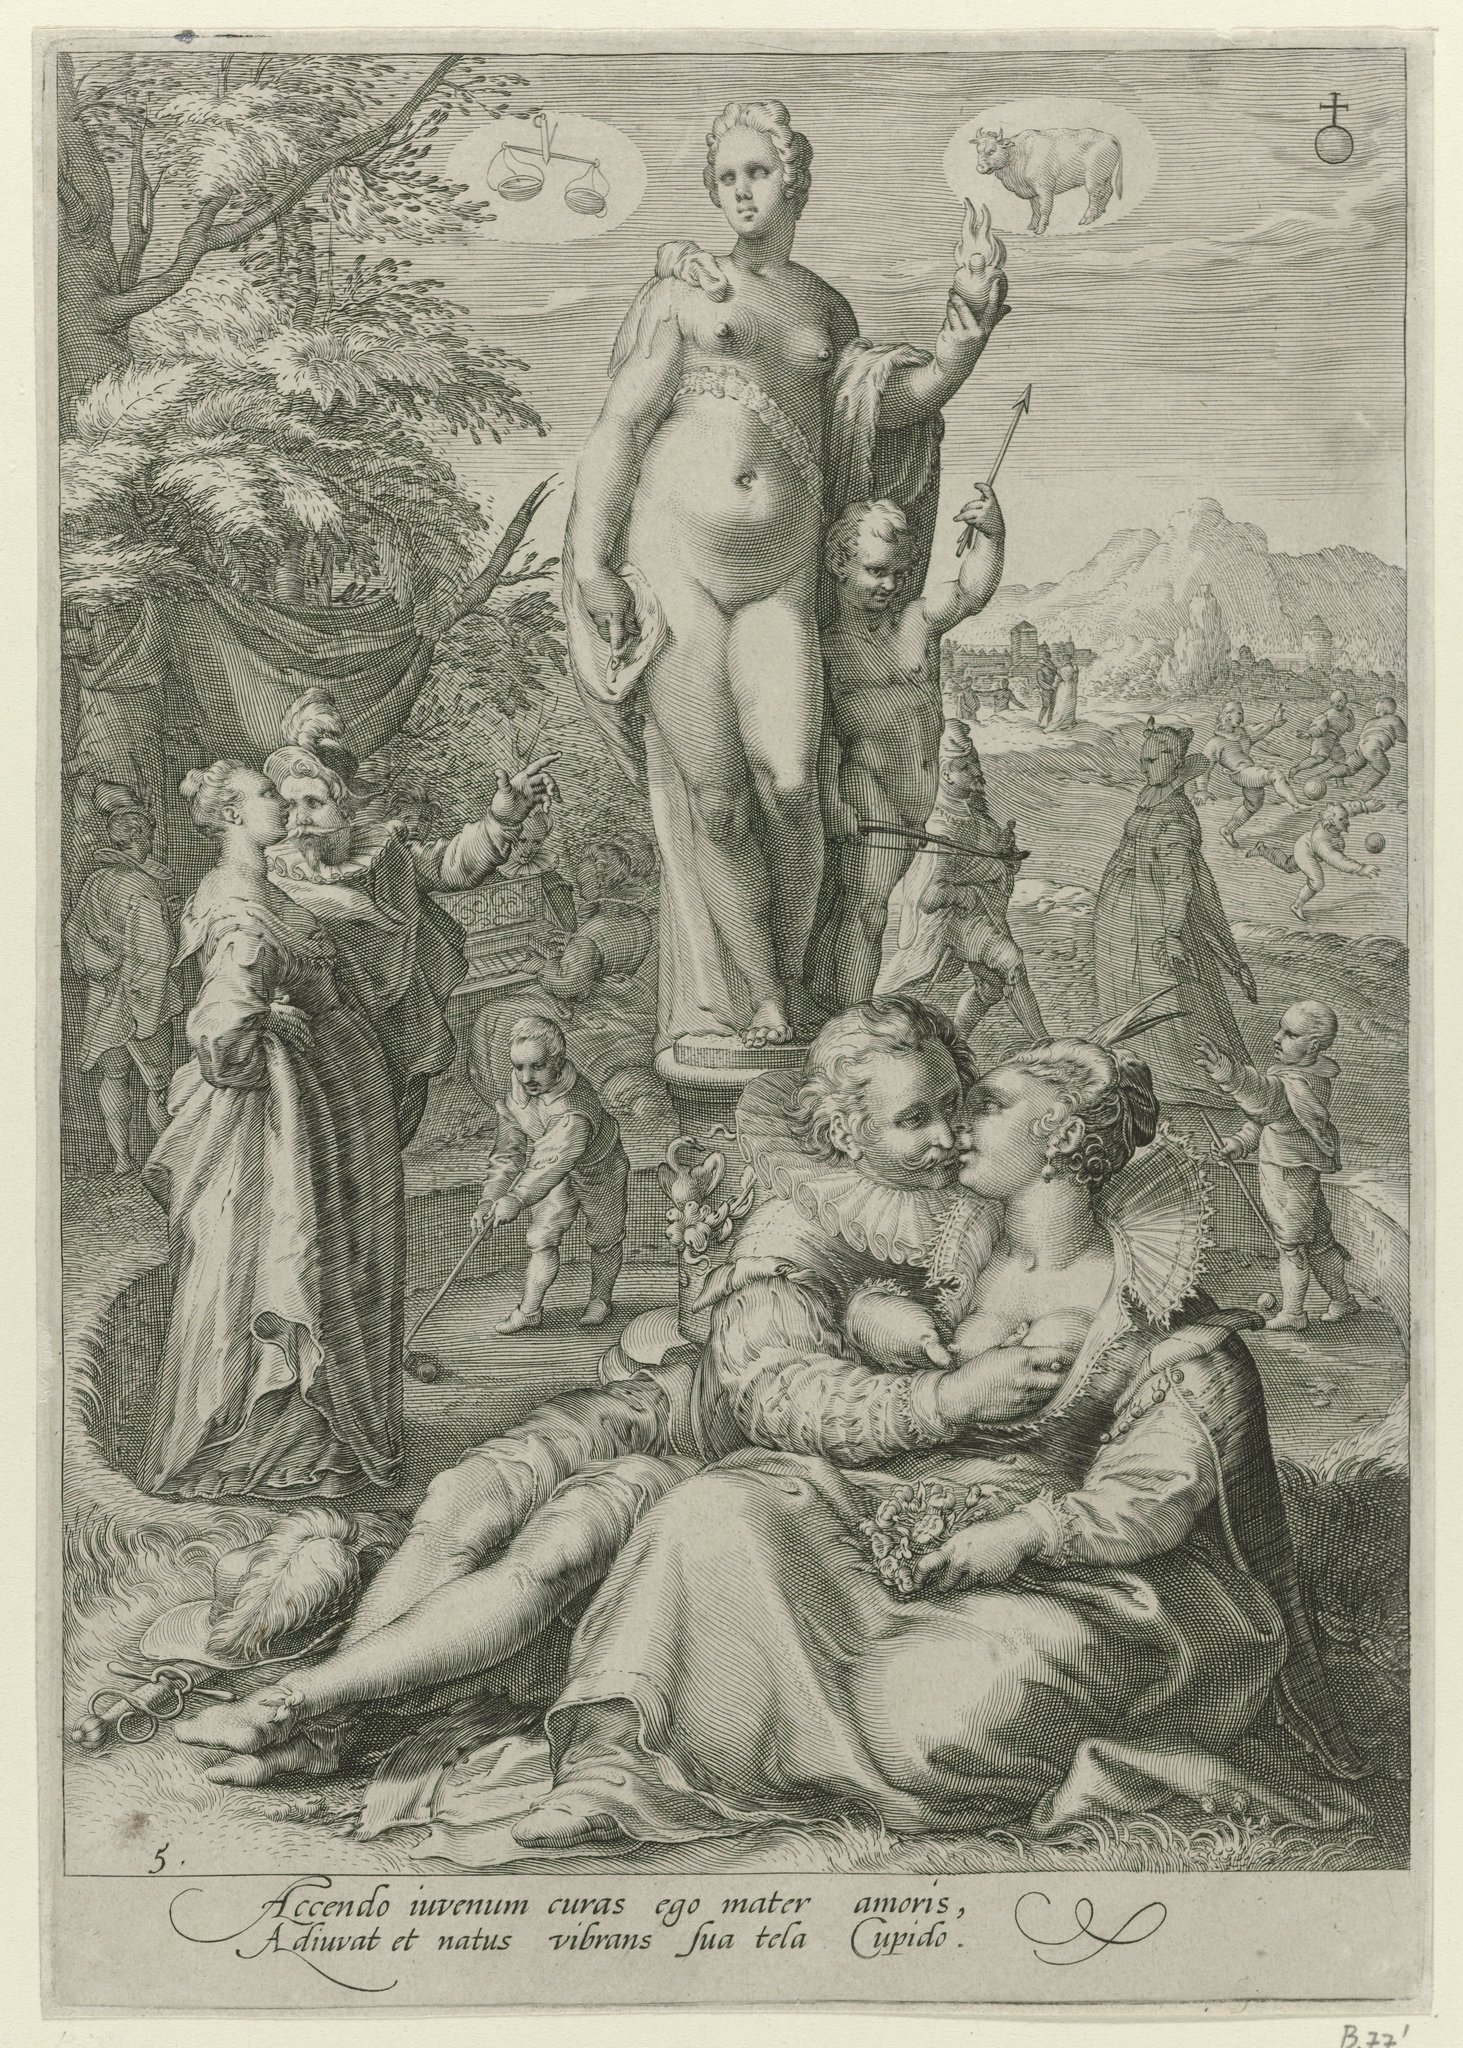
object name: print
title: De zeven planeetgoden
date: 1596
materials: paper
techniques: engraving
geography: northern netherlands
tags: (story of) cupid, amor (eros), (story of) venus (aphrodite), open-air recreation, lovers; courting, flirting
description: Te midden van recreërende figuren op een veld staat de naakte Venus als heerseres over het koninkrijk der liefde op een sokkel. In haar hand houdt Venus een brandend hart. Naast haar staat Amor met pijl en boog. Op de voorgrond zit een minnekozend paar in het gras. In de lucht de symbolen van de sterrenbeelden weegschaal (links), stier (midden) en van Venus (rechts).